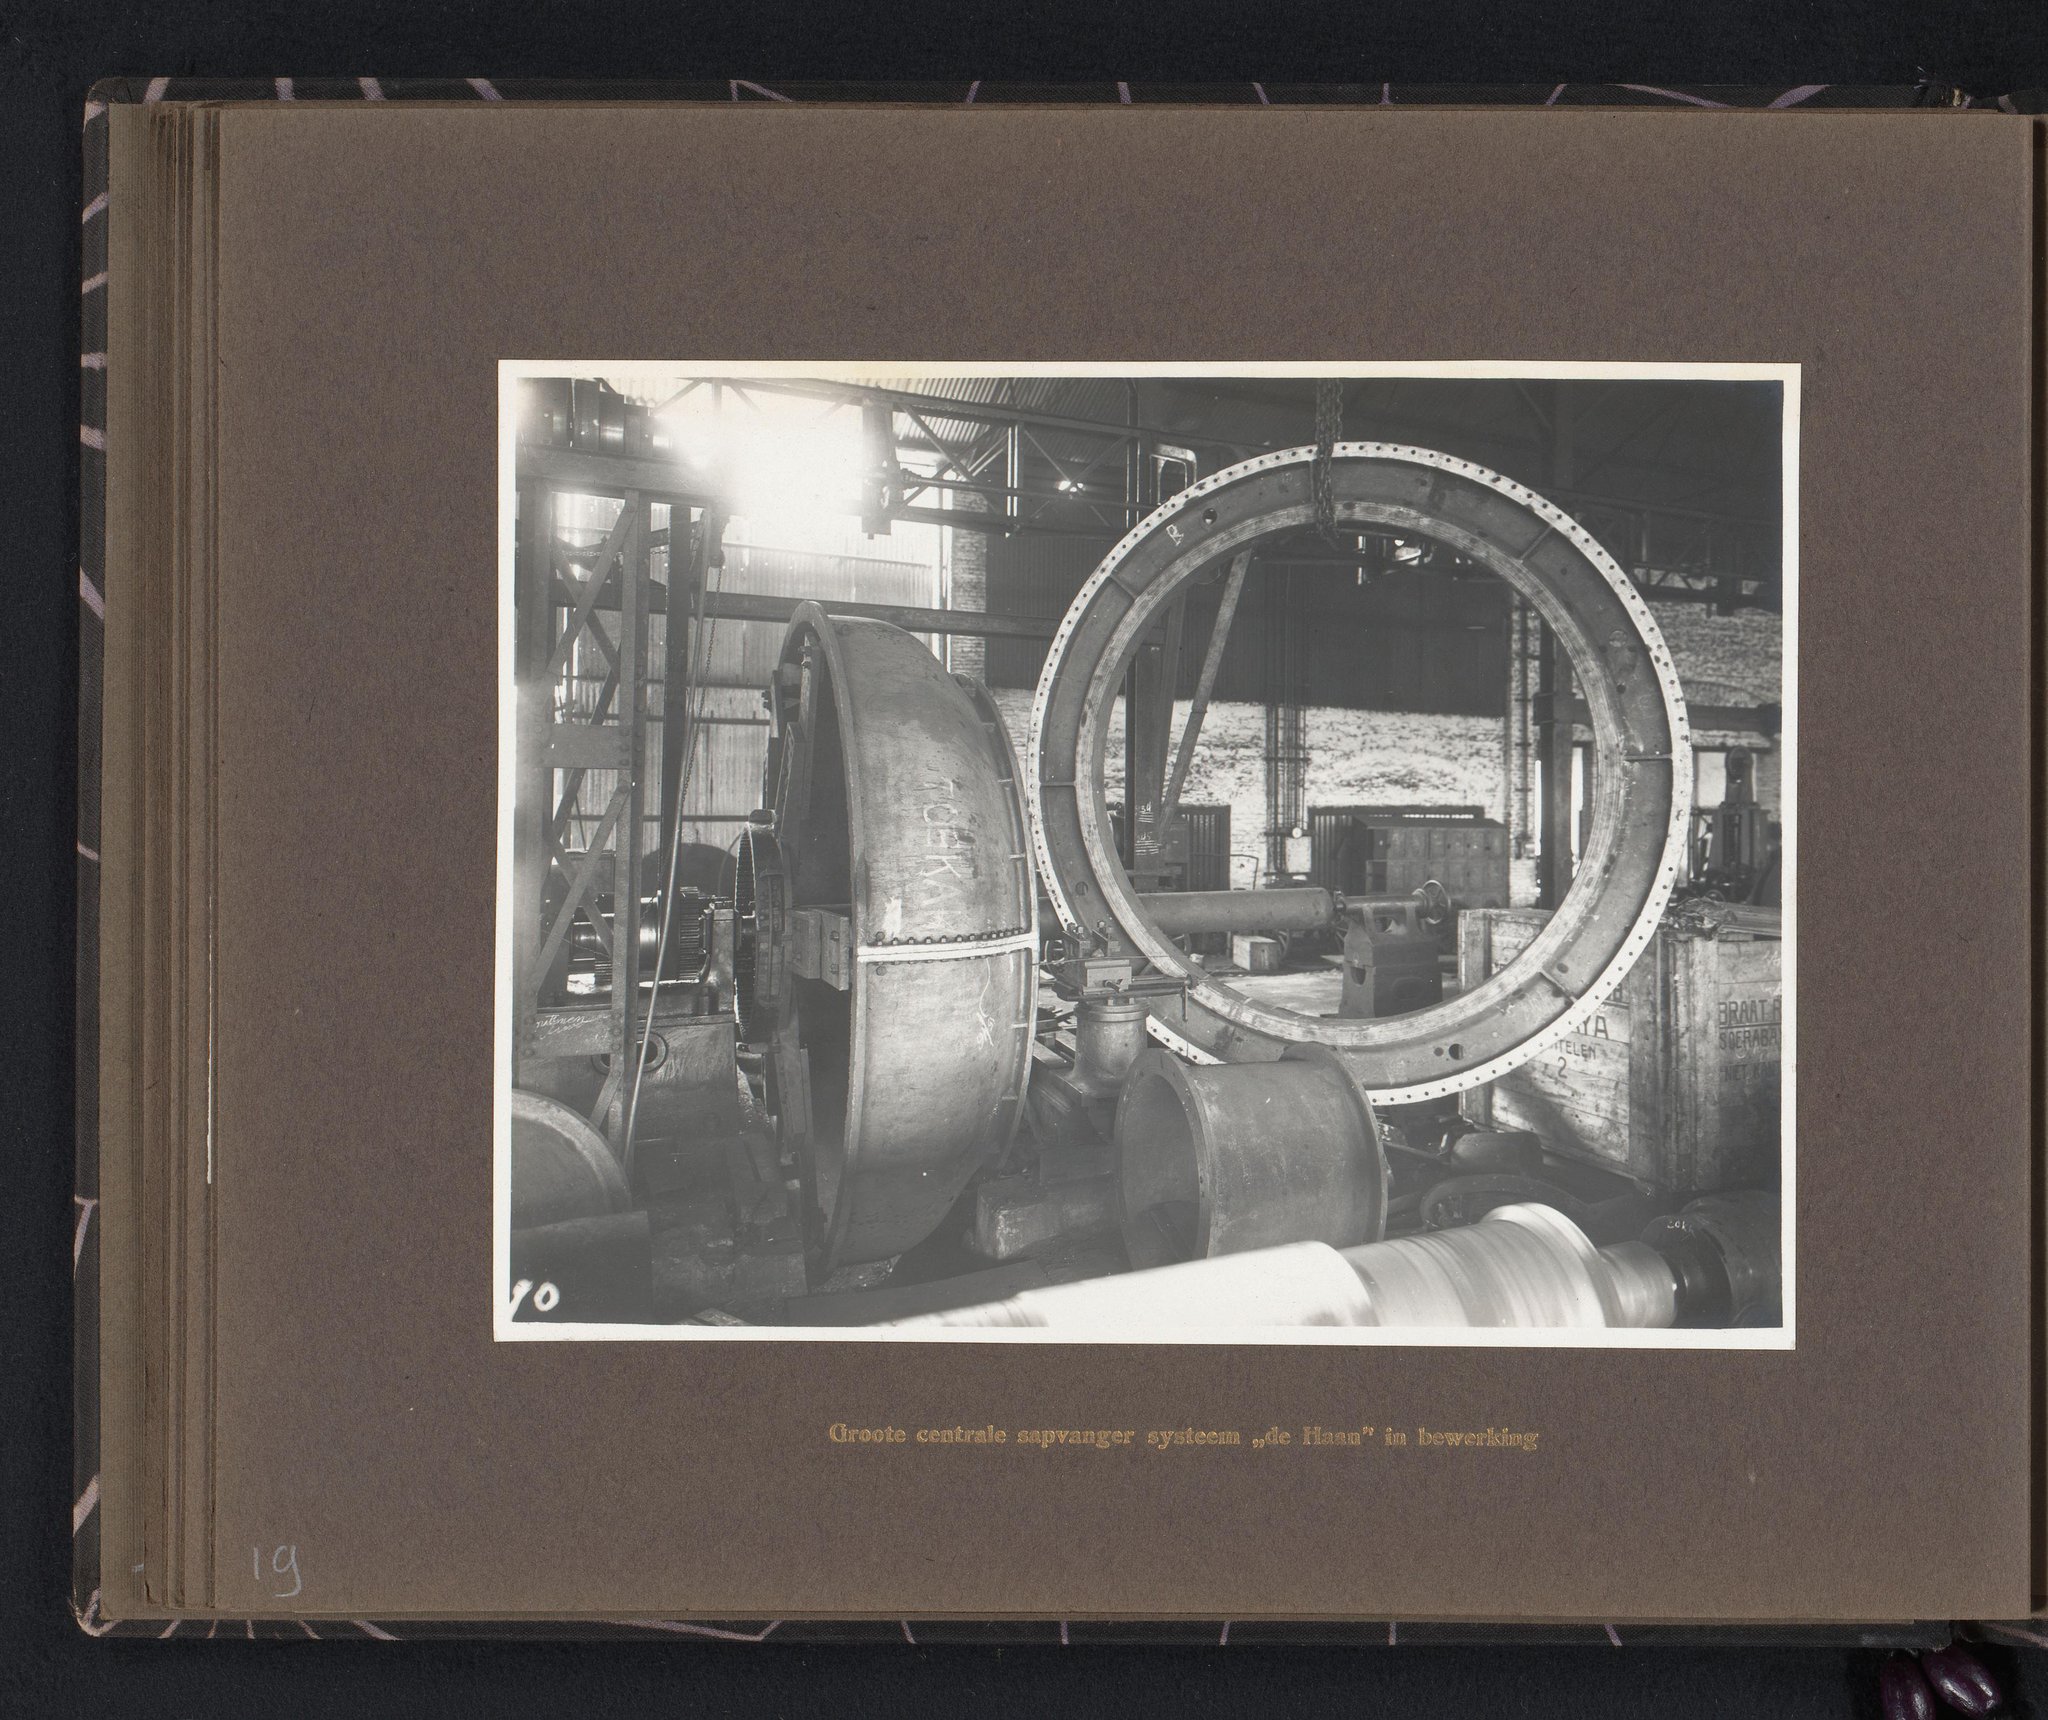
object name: album leaf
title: Groote centrale sapvanger systeem "de Haan" in bewerking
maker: Anonymous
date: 1916-1924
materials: cardboard, photographic support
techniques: gelatin silver print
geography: surabaya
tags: colonial system, factory-interior, machine shop, machines; parts of machines; tools and appliances, java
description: Albumblad met een foto van een onderdeel van een machine. Vervaardigd door Machinefabriek Braat. Onderdeel van het fotoalbum Machinefabriek Braat Soerabaia-Djocja-Tegal, ca. 1916-1924.